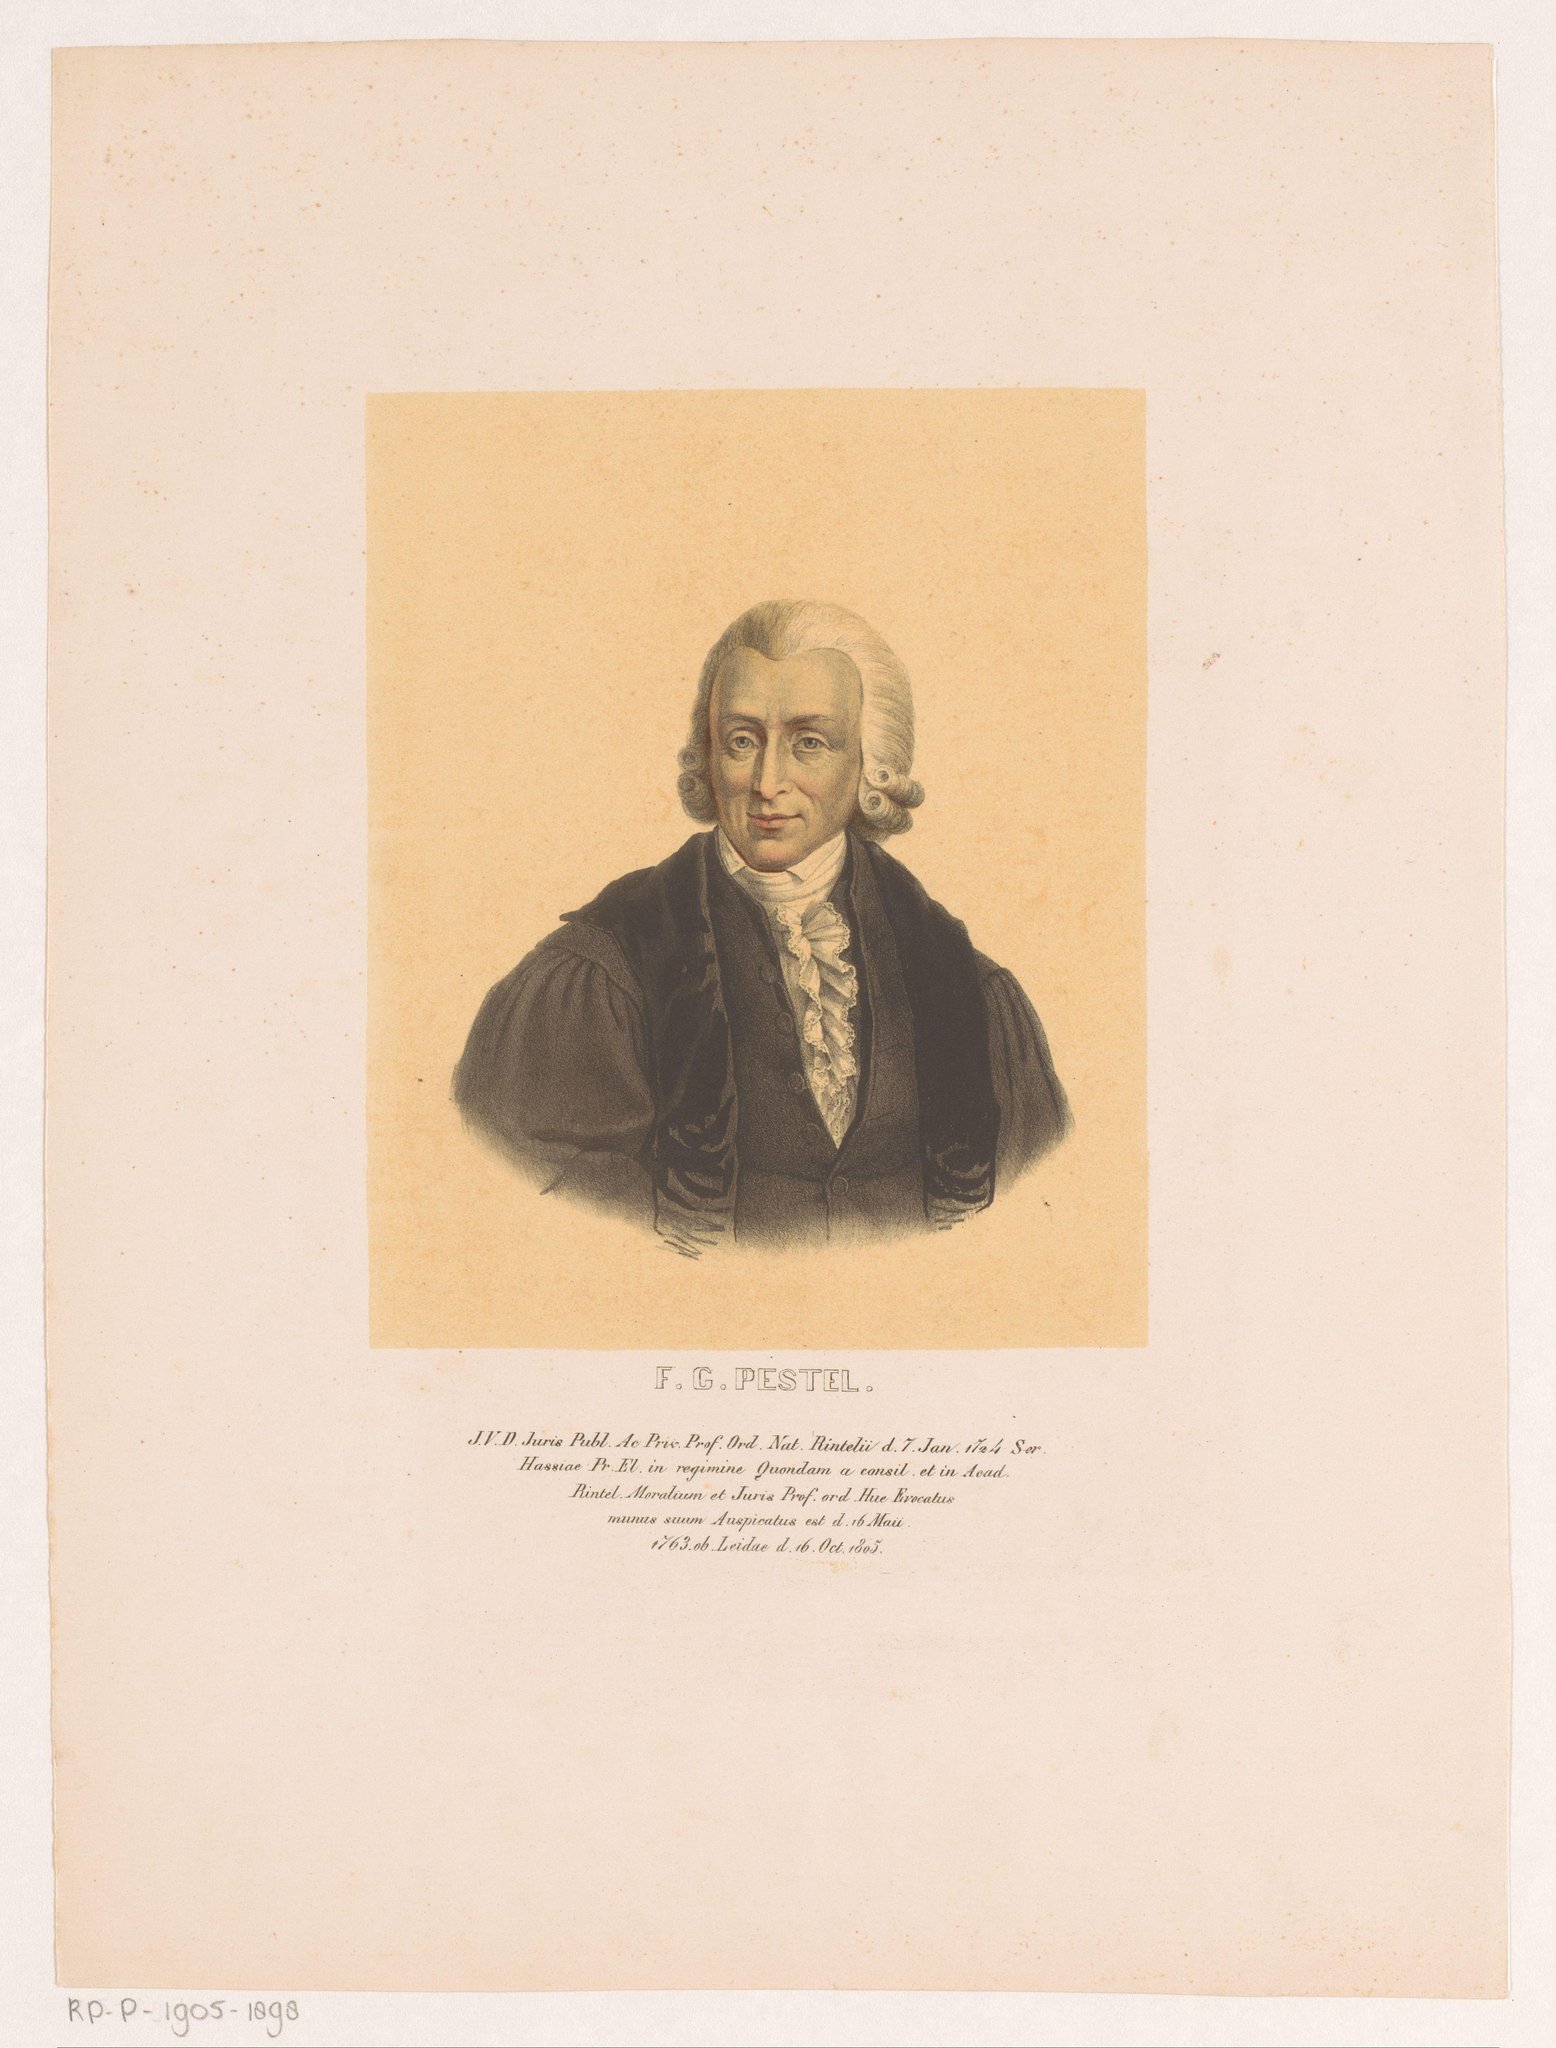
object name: print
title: F.G. Pestel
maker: leendert springer (i)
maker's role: draughtsman, painter, print maker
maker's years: 1789-1871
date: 1850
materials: paper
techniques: lithograph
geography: leiden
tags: historical persons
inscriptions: collector's mark: Lugt 2228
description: Prent uit: Springer, Leendert. Galerij van hoogleeraren aan de Hoogeschool te Leijden, naar de oorspronkelijke afbeeldsels op de Senaat-zaal aldaar berustende. Leiden: Springer, Leendert., s.a. [circa 1850].